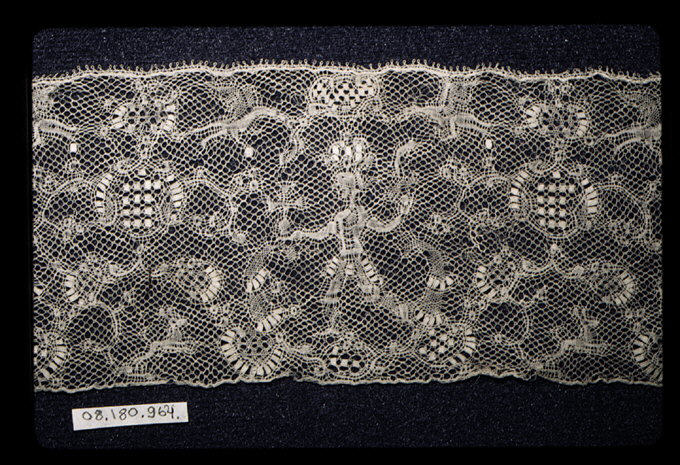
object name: strip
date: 1701-1733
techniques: lace